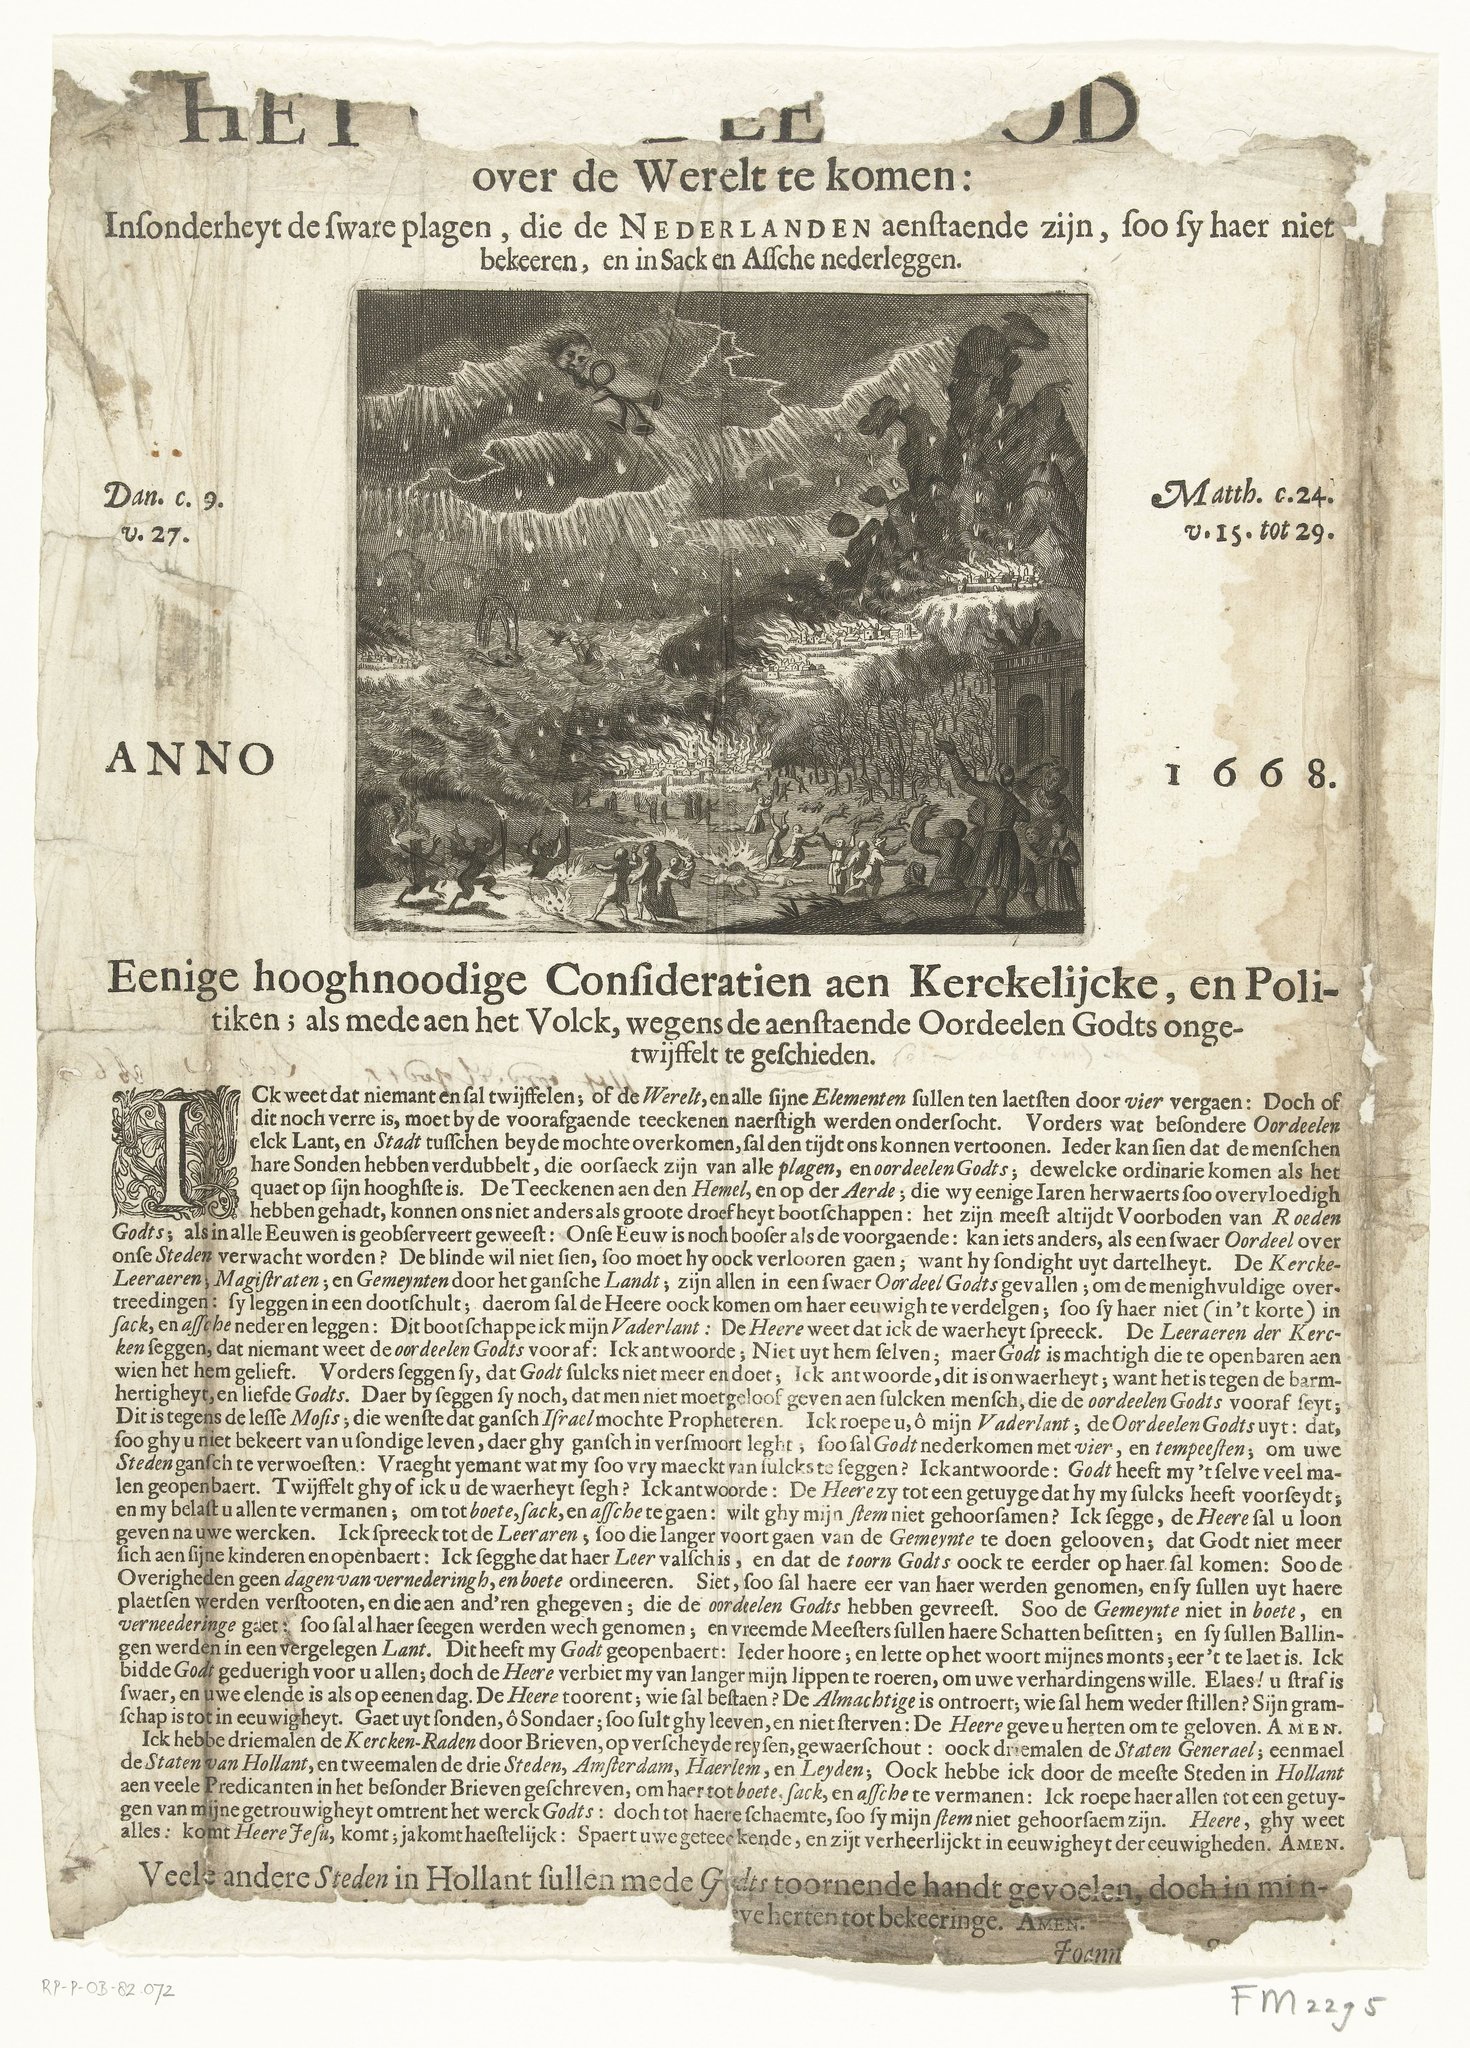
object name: print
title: Het oordeel Godts over de Werelt de komen: Insonderheyt de sware plagen, die de Nederlanden aenstaende zijn, soo sy haer niet bekeeren, en in Sack en Assche nederleggen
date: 1668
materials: paper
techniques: etching, letterpress printing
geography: low countries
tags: third vision of daniel (daniel 9): the archangel gabriel explains to daniel the meaning of the 'seventy weeks', 'watch therefore, for you do not know on what day your lord is coming' ~ doctrine of christ on the kingdom of heaven (matthew 24:42-44, 25:13; luke 12:40), sayings of christ: discourse on the last things (matthew 24; mark 13; luke 21)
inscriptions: date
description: Waarschuwing over de aanstaande bestraffing van het land door God, 1668. Blad met een prent van de plagen die de Nederlanden zullen treffen: vuur vanuit de hemel, brandende steden, stormen die overstromingen brengen en bomen afbreken. Bergen vallen om, walvis op zee, dansend duivels met fakkels, in de wolken blaast een engel op een bazuin. Onder de plaat gedrukt op het blad een beschrijving van de plagen en de oproep tot bekering.